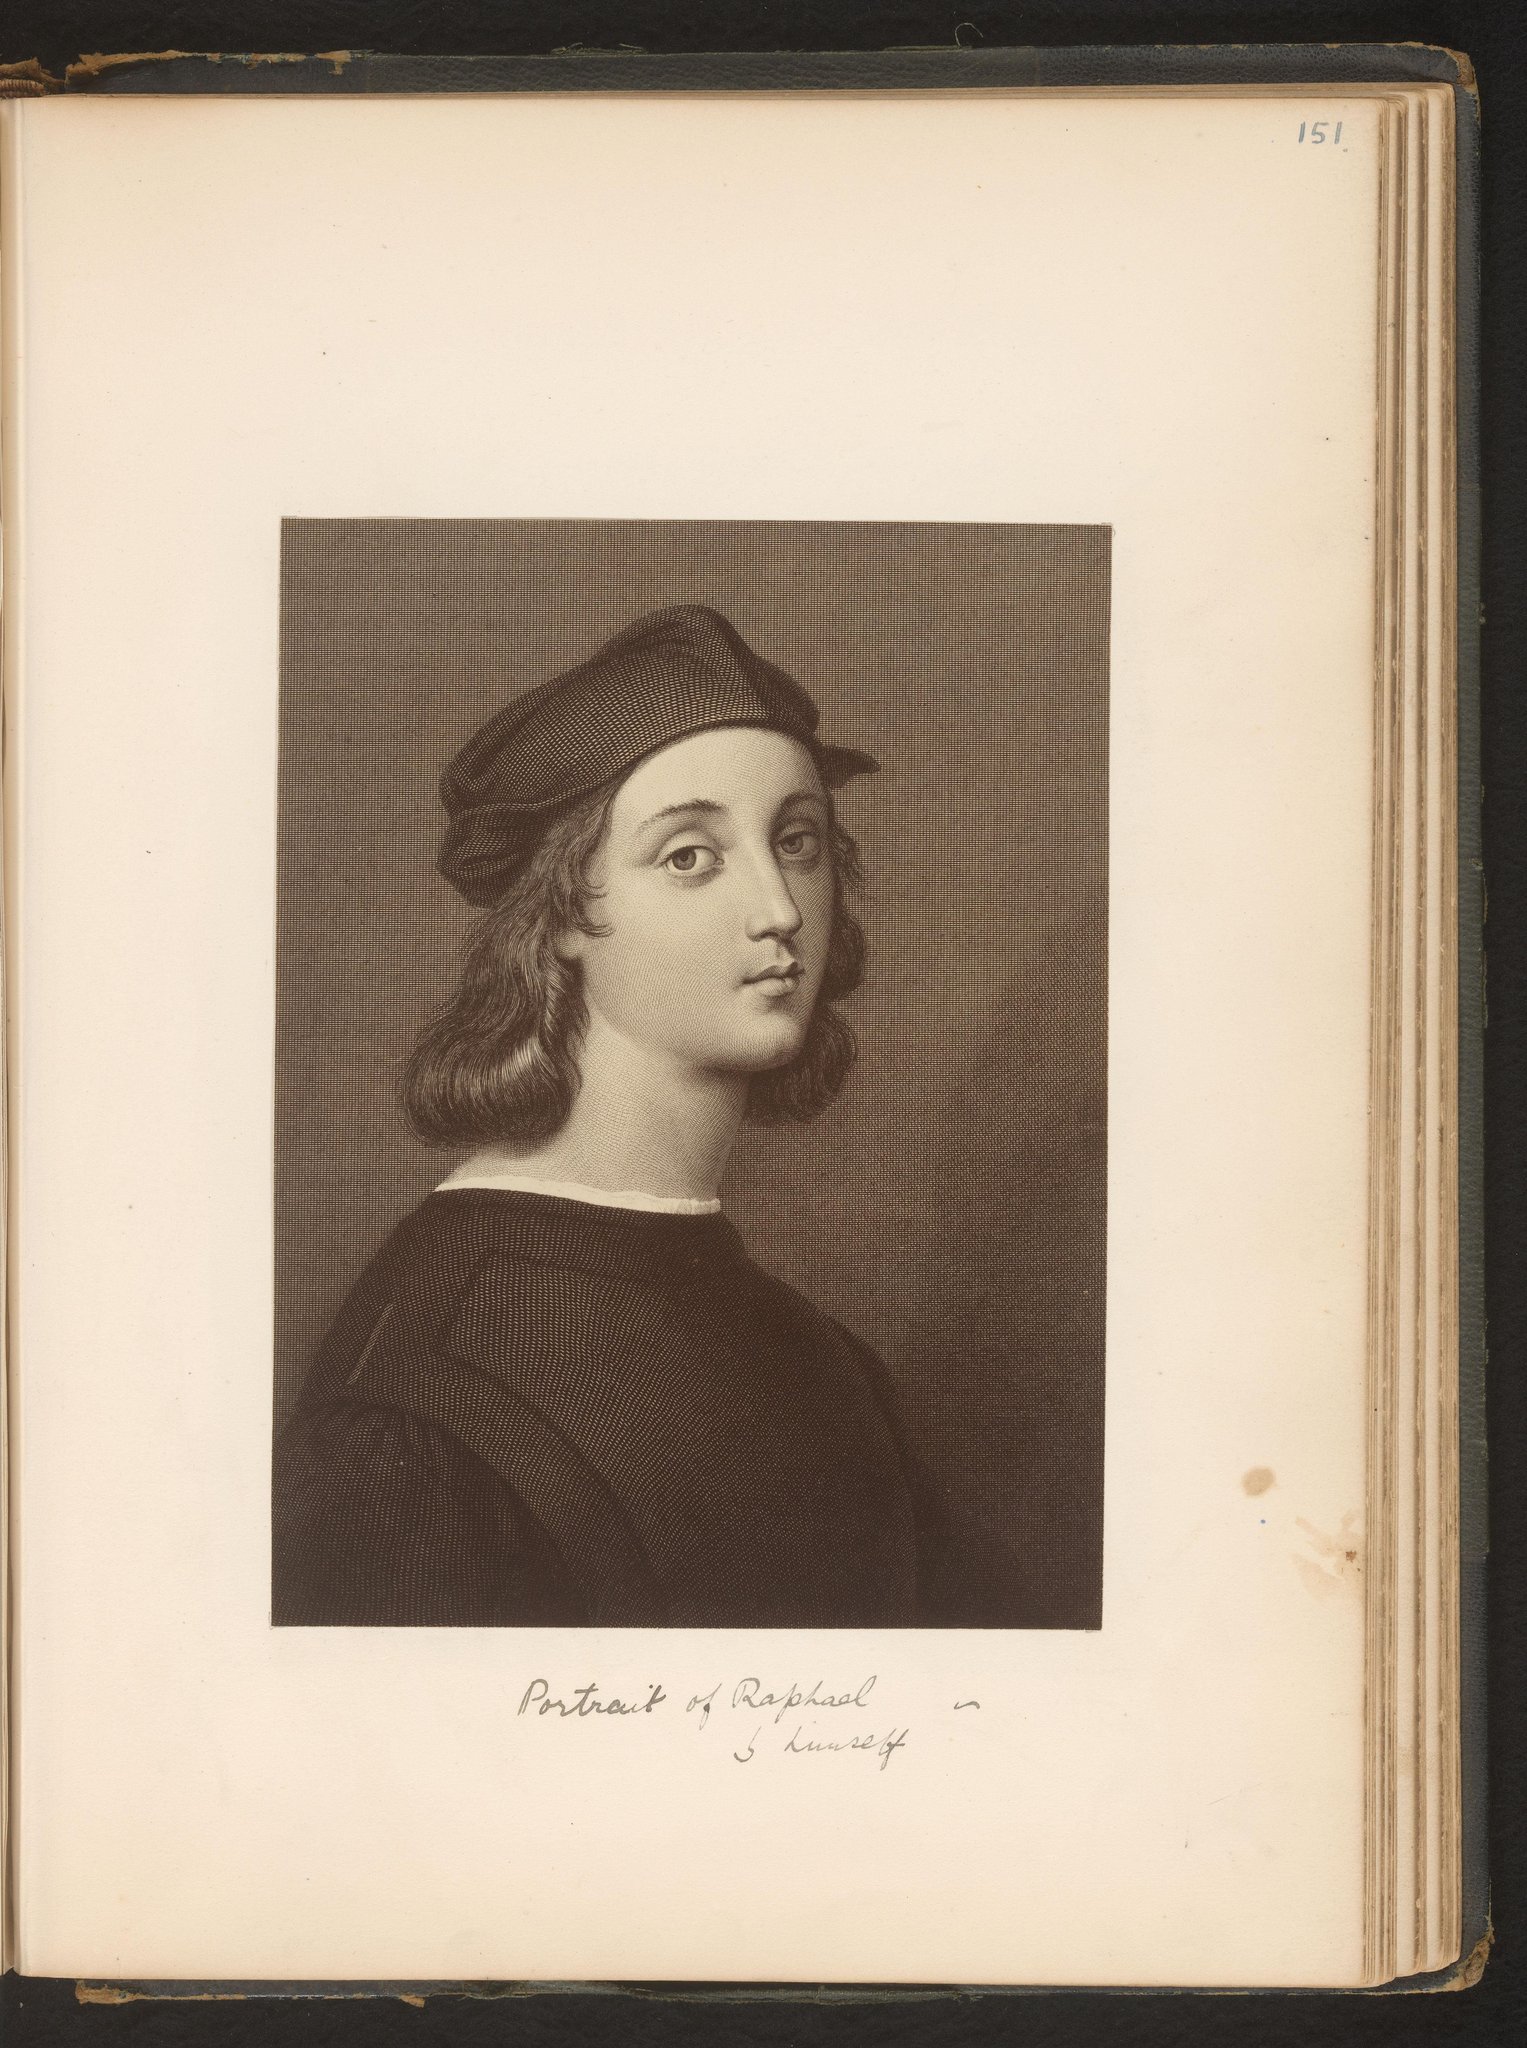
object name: photograph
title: Fotoreproductie van een prent; een zelfportret van Rafaël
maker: Anonymous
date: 1810-1873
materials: paper, photographic support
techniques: albumen print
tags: rome, painter, rafaël, print, e.g.: engraving, etching, lithograph, portrait, self-portrait of artist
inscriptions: annotation: ‘Portrait of Raphael by himself’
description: Deze pagina maakt deel uit van een album.